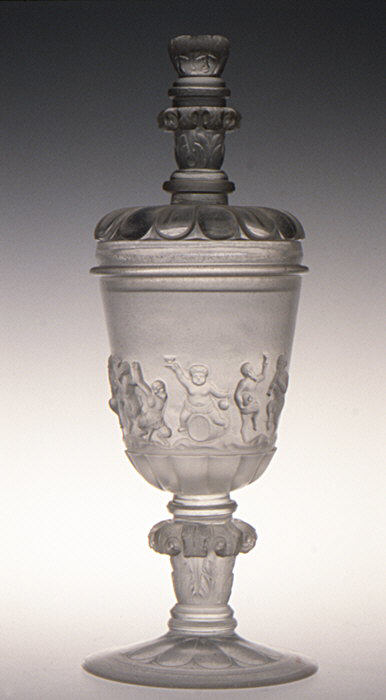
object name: standing cup with cover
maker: franz gundelach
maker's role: engraver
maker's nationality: german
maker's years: 1650-1750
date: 1700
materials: glass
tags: men,female nudes,putti